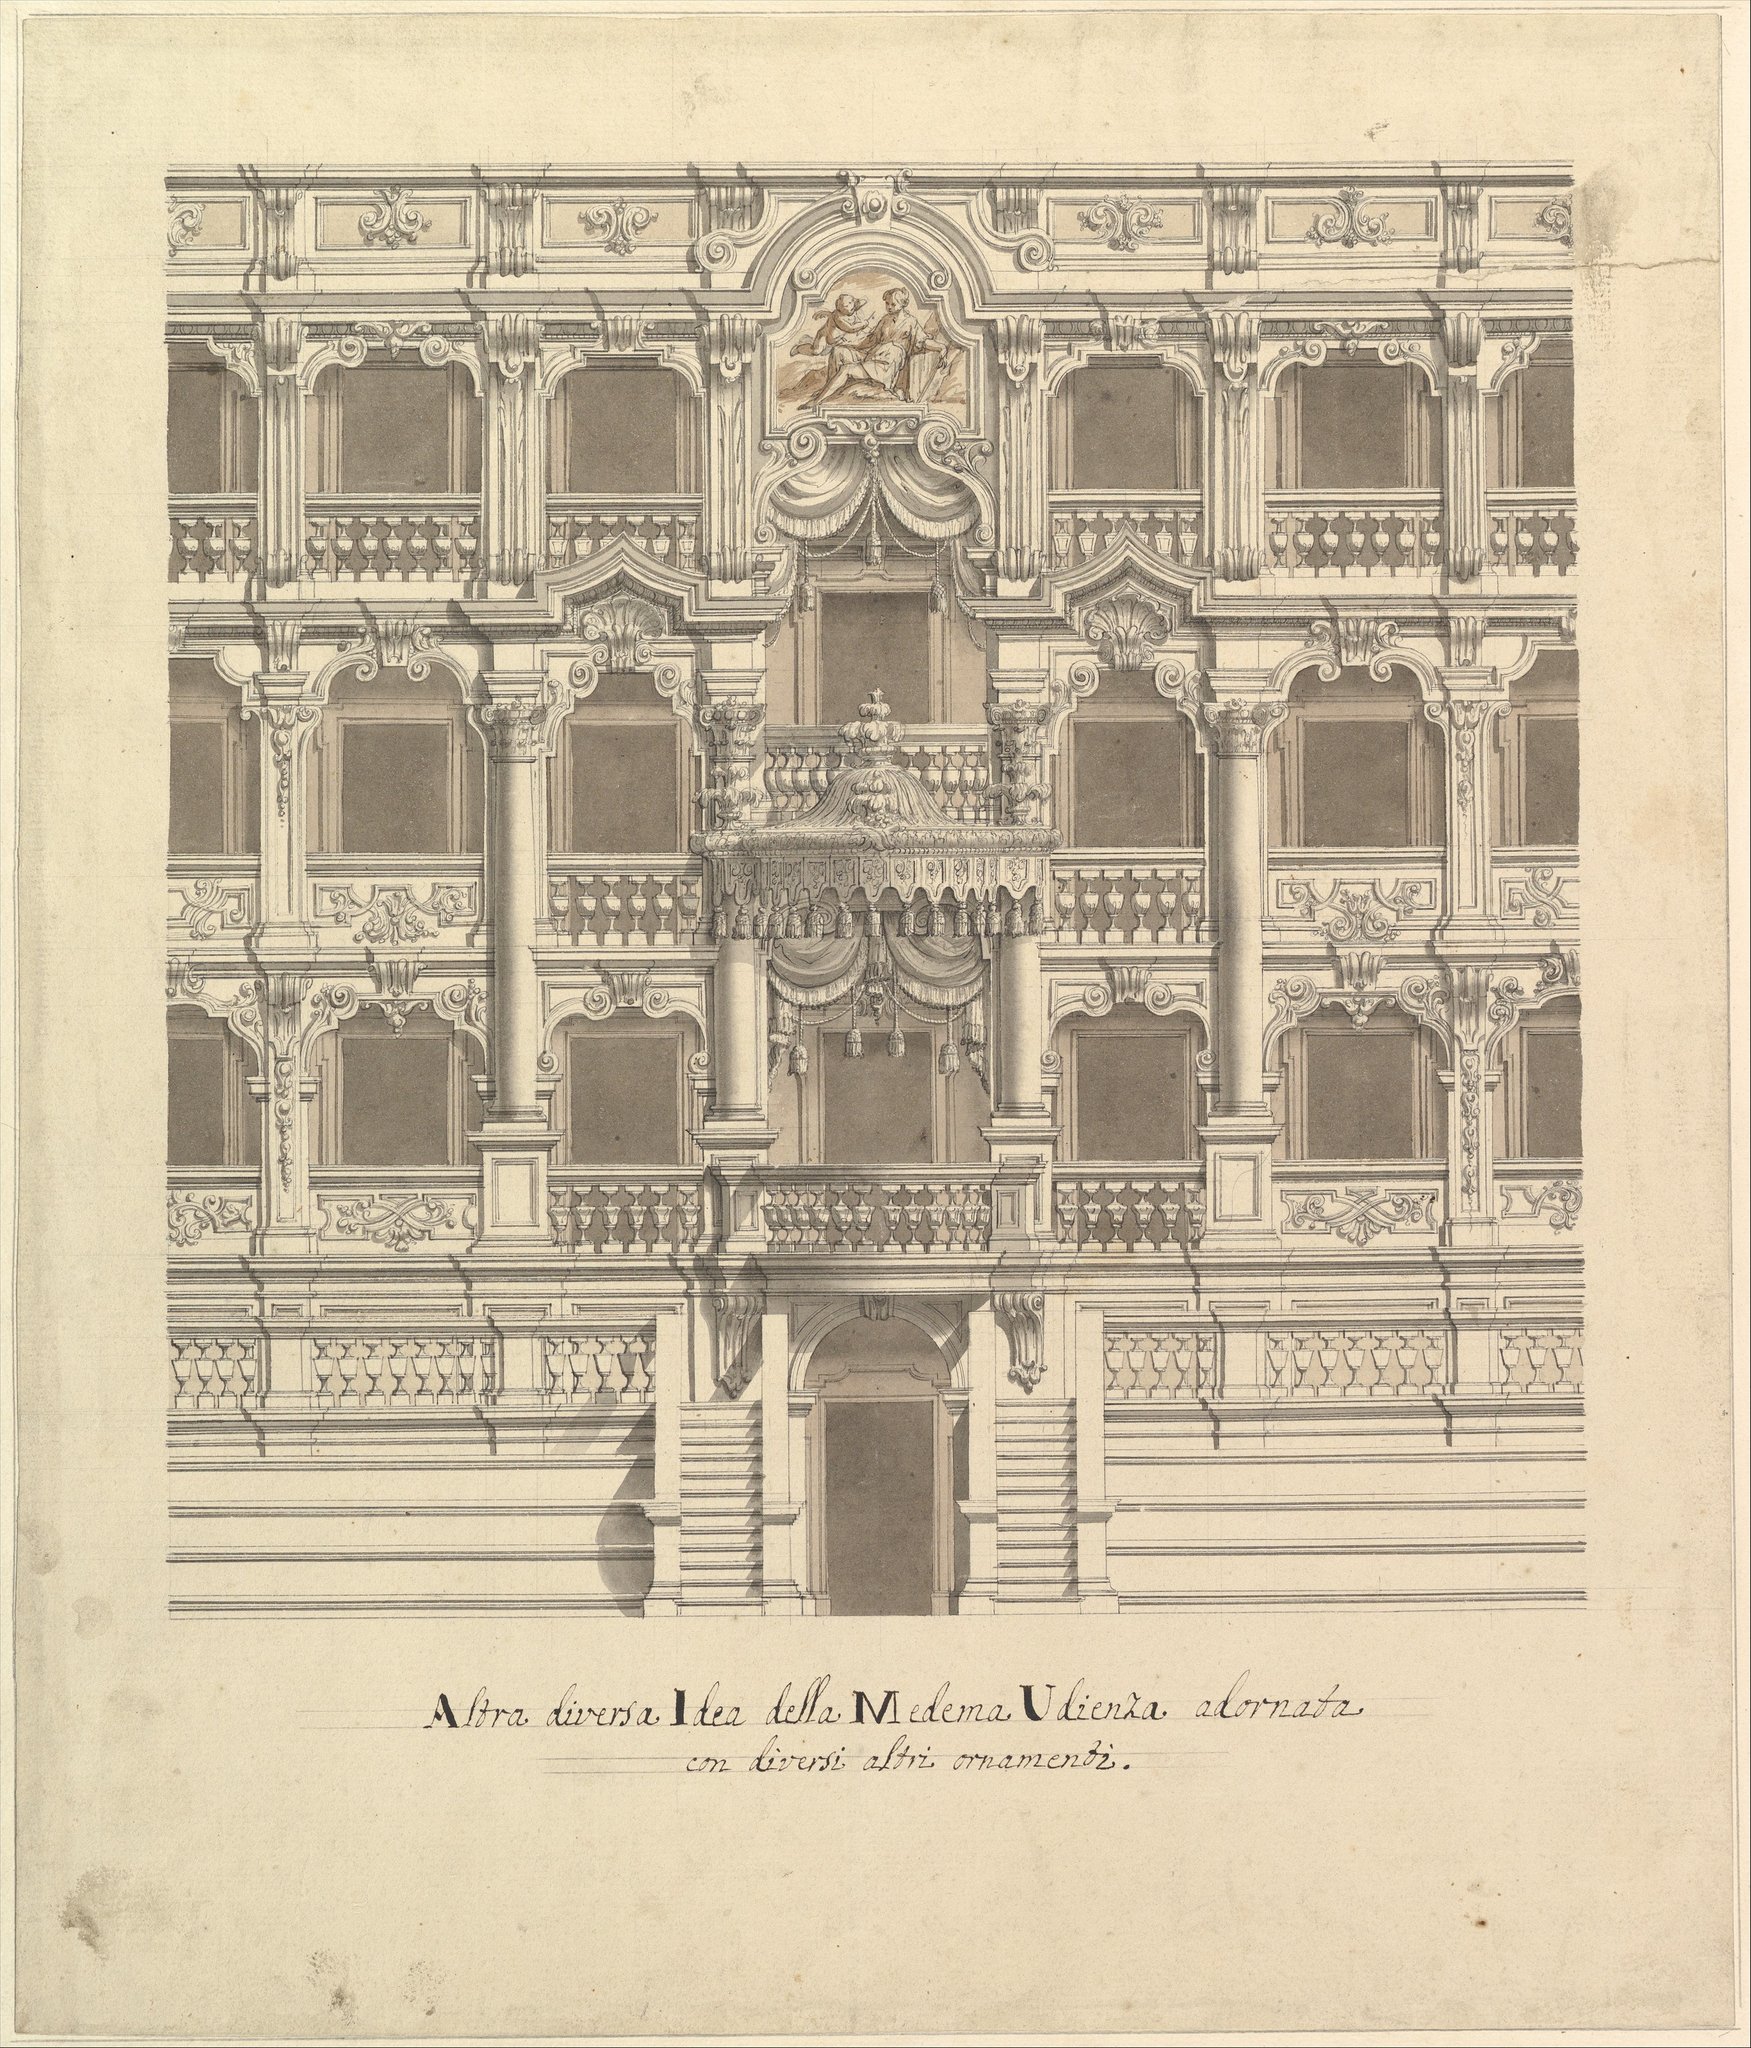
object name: drawing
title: Views of a Theater (Bayreuth): Interior Elevation of the Theater Showing Royal Box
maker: giuseppe galli bibiena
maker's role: artist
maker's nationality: italian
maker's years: 1696-1756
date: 1696-1756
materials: ink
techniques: pen, wash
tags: theatre,architecture